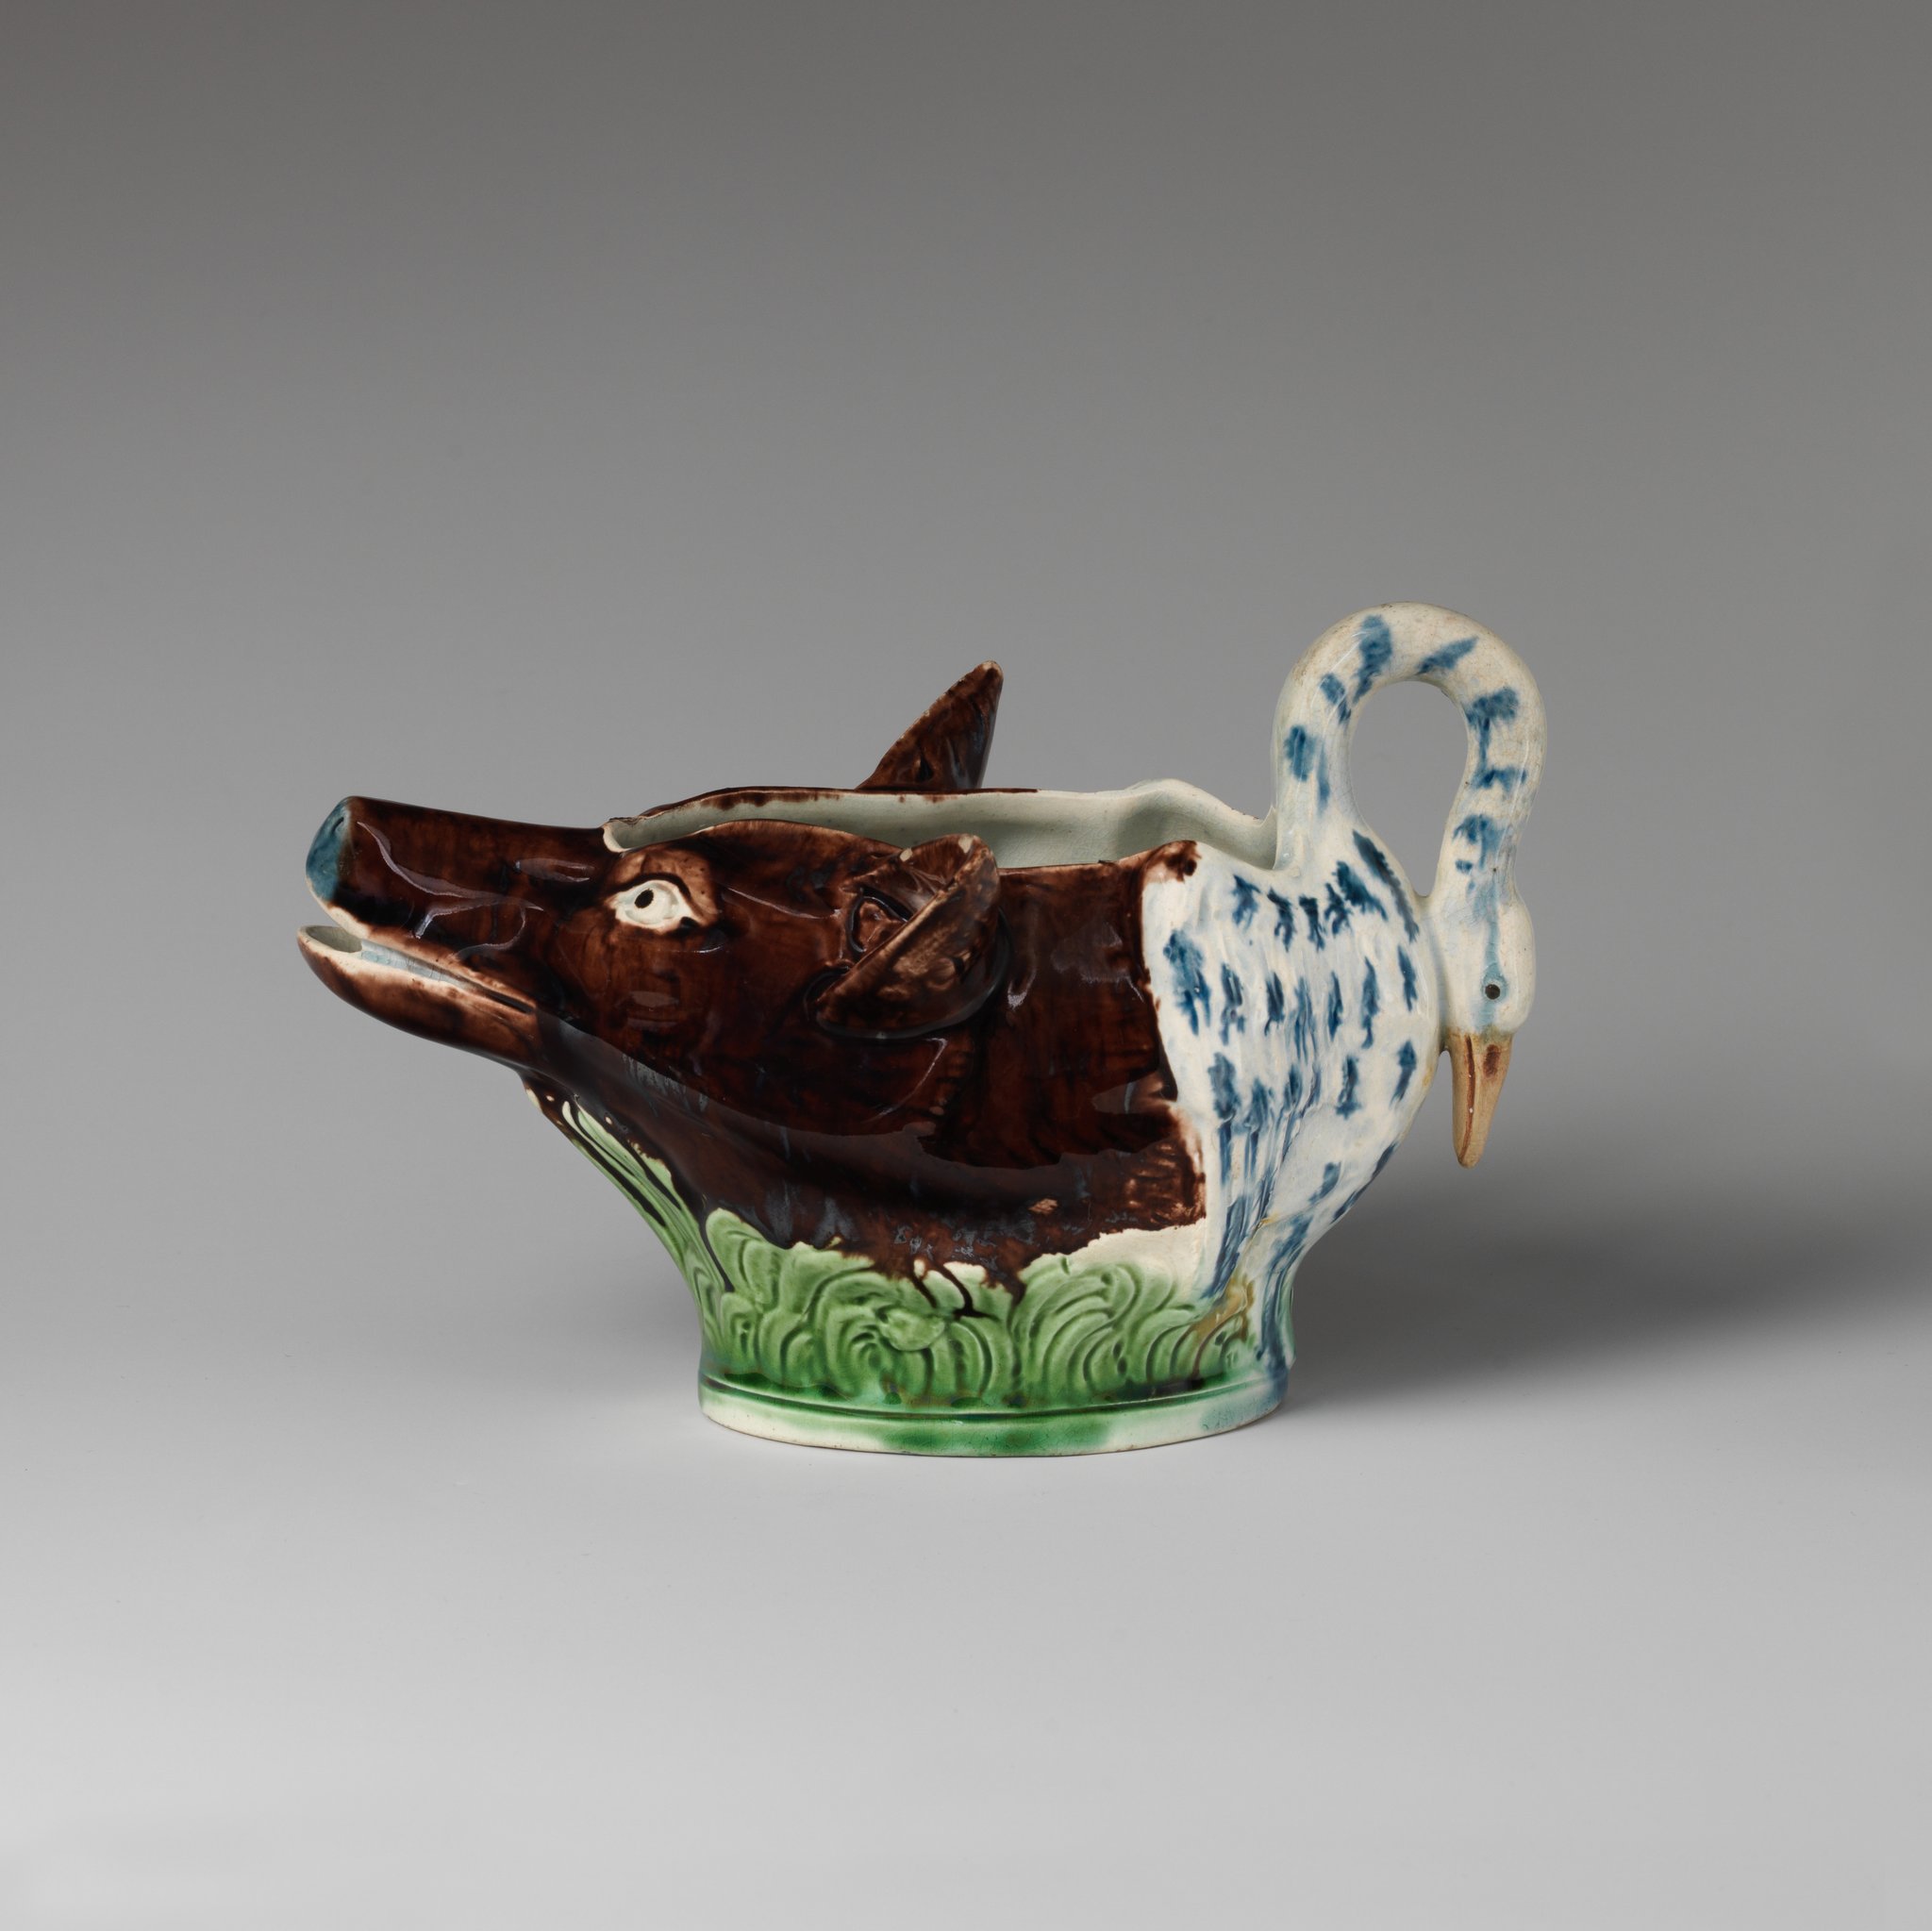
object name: sauceboat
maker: ralph wood the younger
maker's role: maker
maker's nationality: british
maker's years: 1748-1795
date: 1770-1780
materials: earthenware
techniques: glazing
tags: swans,foxes